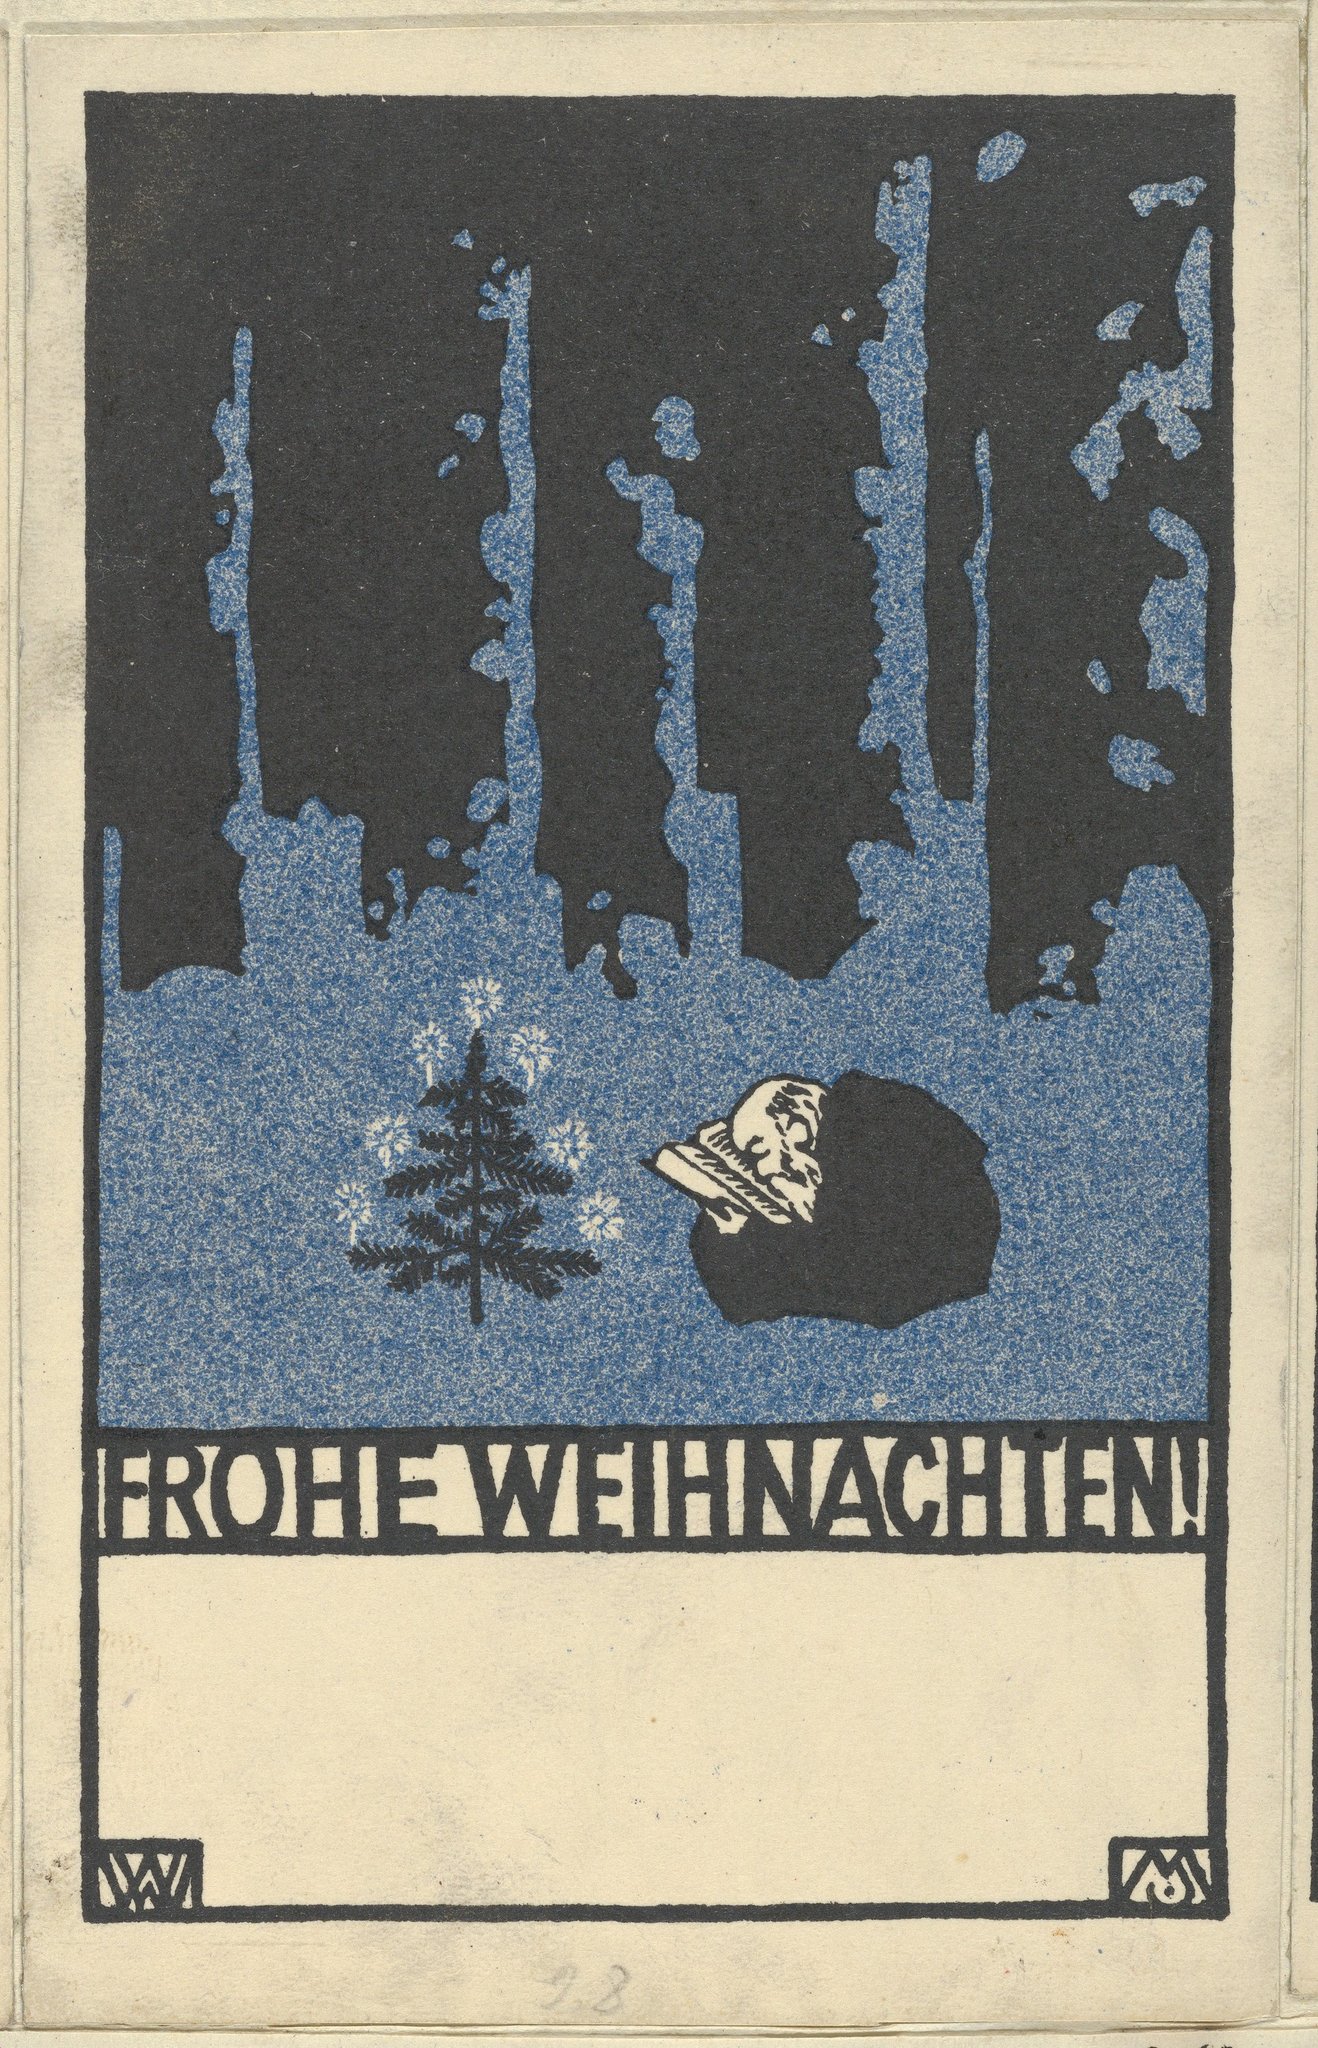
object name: print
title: Merry Christmas! (Frohe Weihnachten!)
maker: moriz jung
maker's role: artist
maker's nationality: austrian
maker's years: 1885-1915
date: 1907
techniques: lithograph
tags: men,reading,trees,christmas